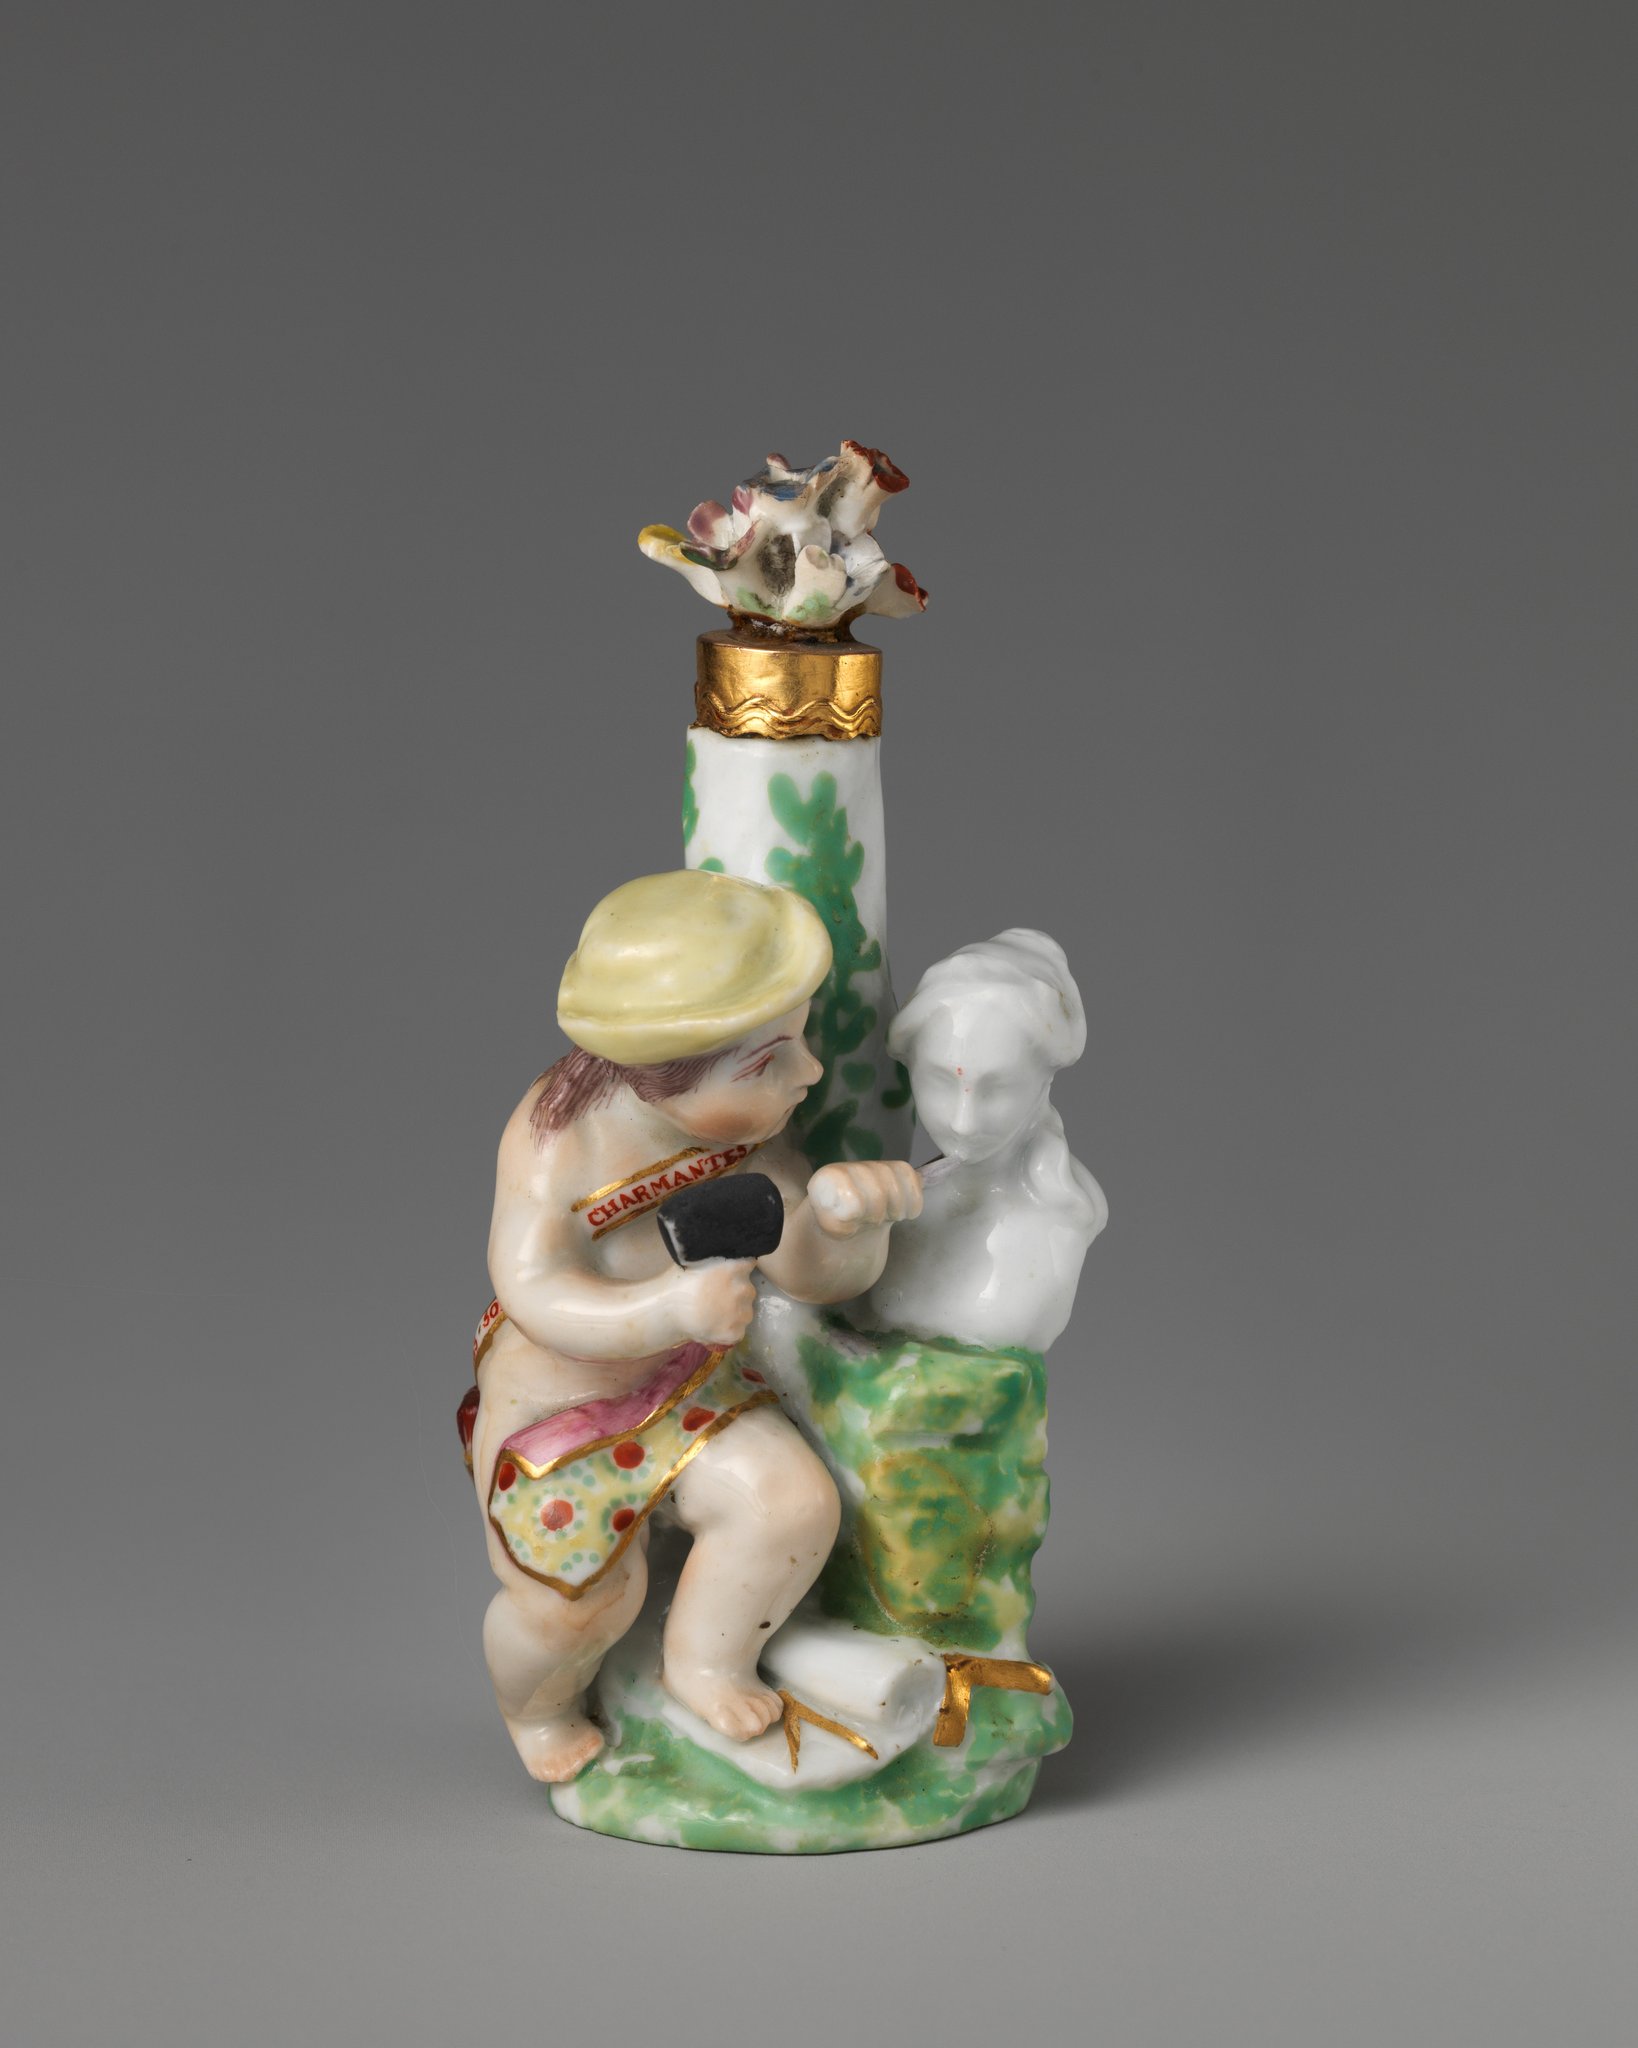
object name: toy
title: Cupid as sculptor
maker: chelsea porcelain manufactory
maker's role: factory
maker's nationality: british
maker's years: 1744-1784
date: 1765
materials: soft paste porcelain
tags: cupid,working